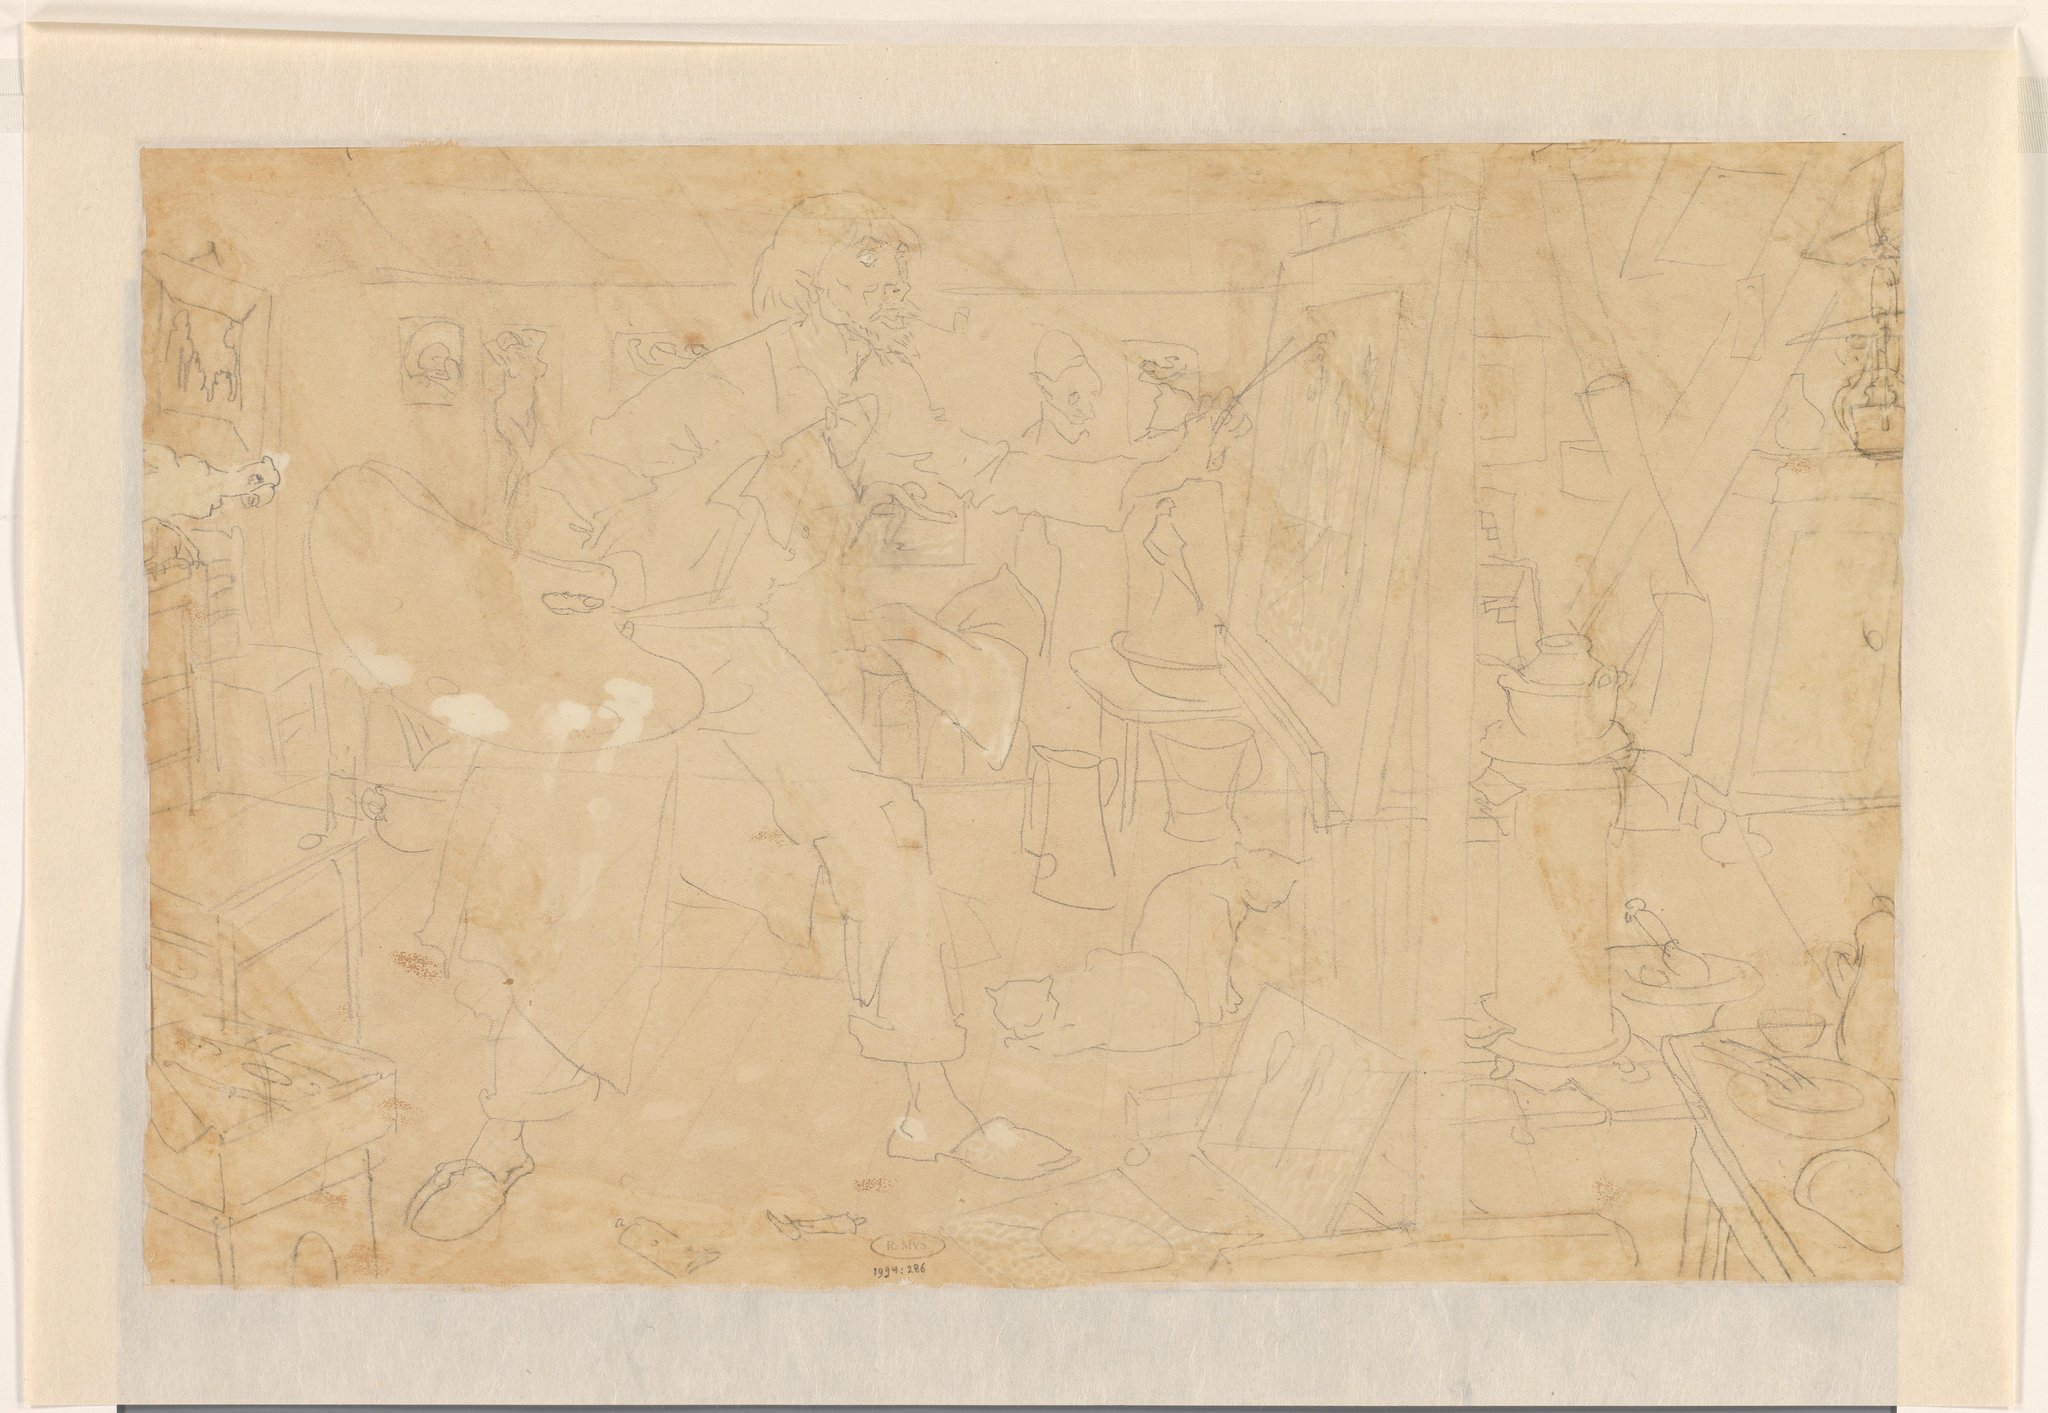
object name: drawing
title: Schilder werkend in zijn atelier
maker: leo gestel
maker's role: draughtsman, print maker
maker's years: 1881-1941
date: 1908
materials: paper, pencil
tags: artist at work, in his workshop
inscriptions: collector's mark: Lugt 2228a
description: Doorgetrokken, spiegelbeeldige studie van de voorstelling op recto.